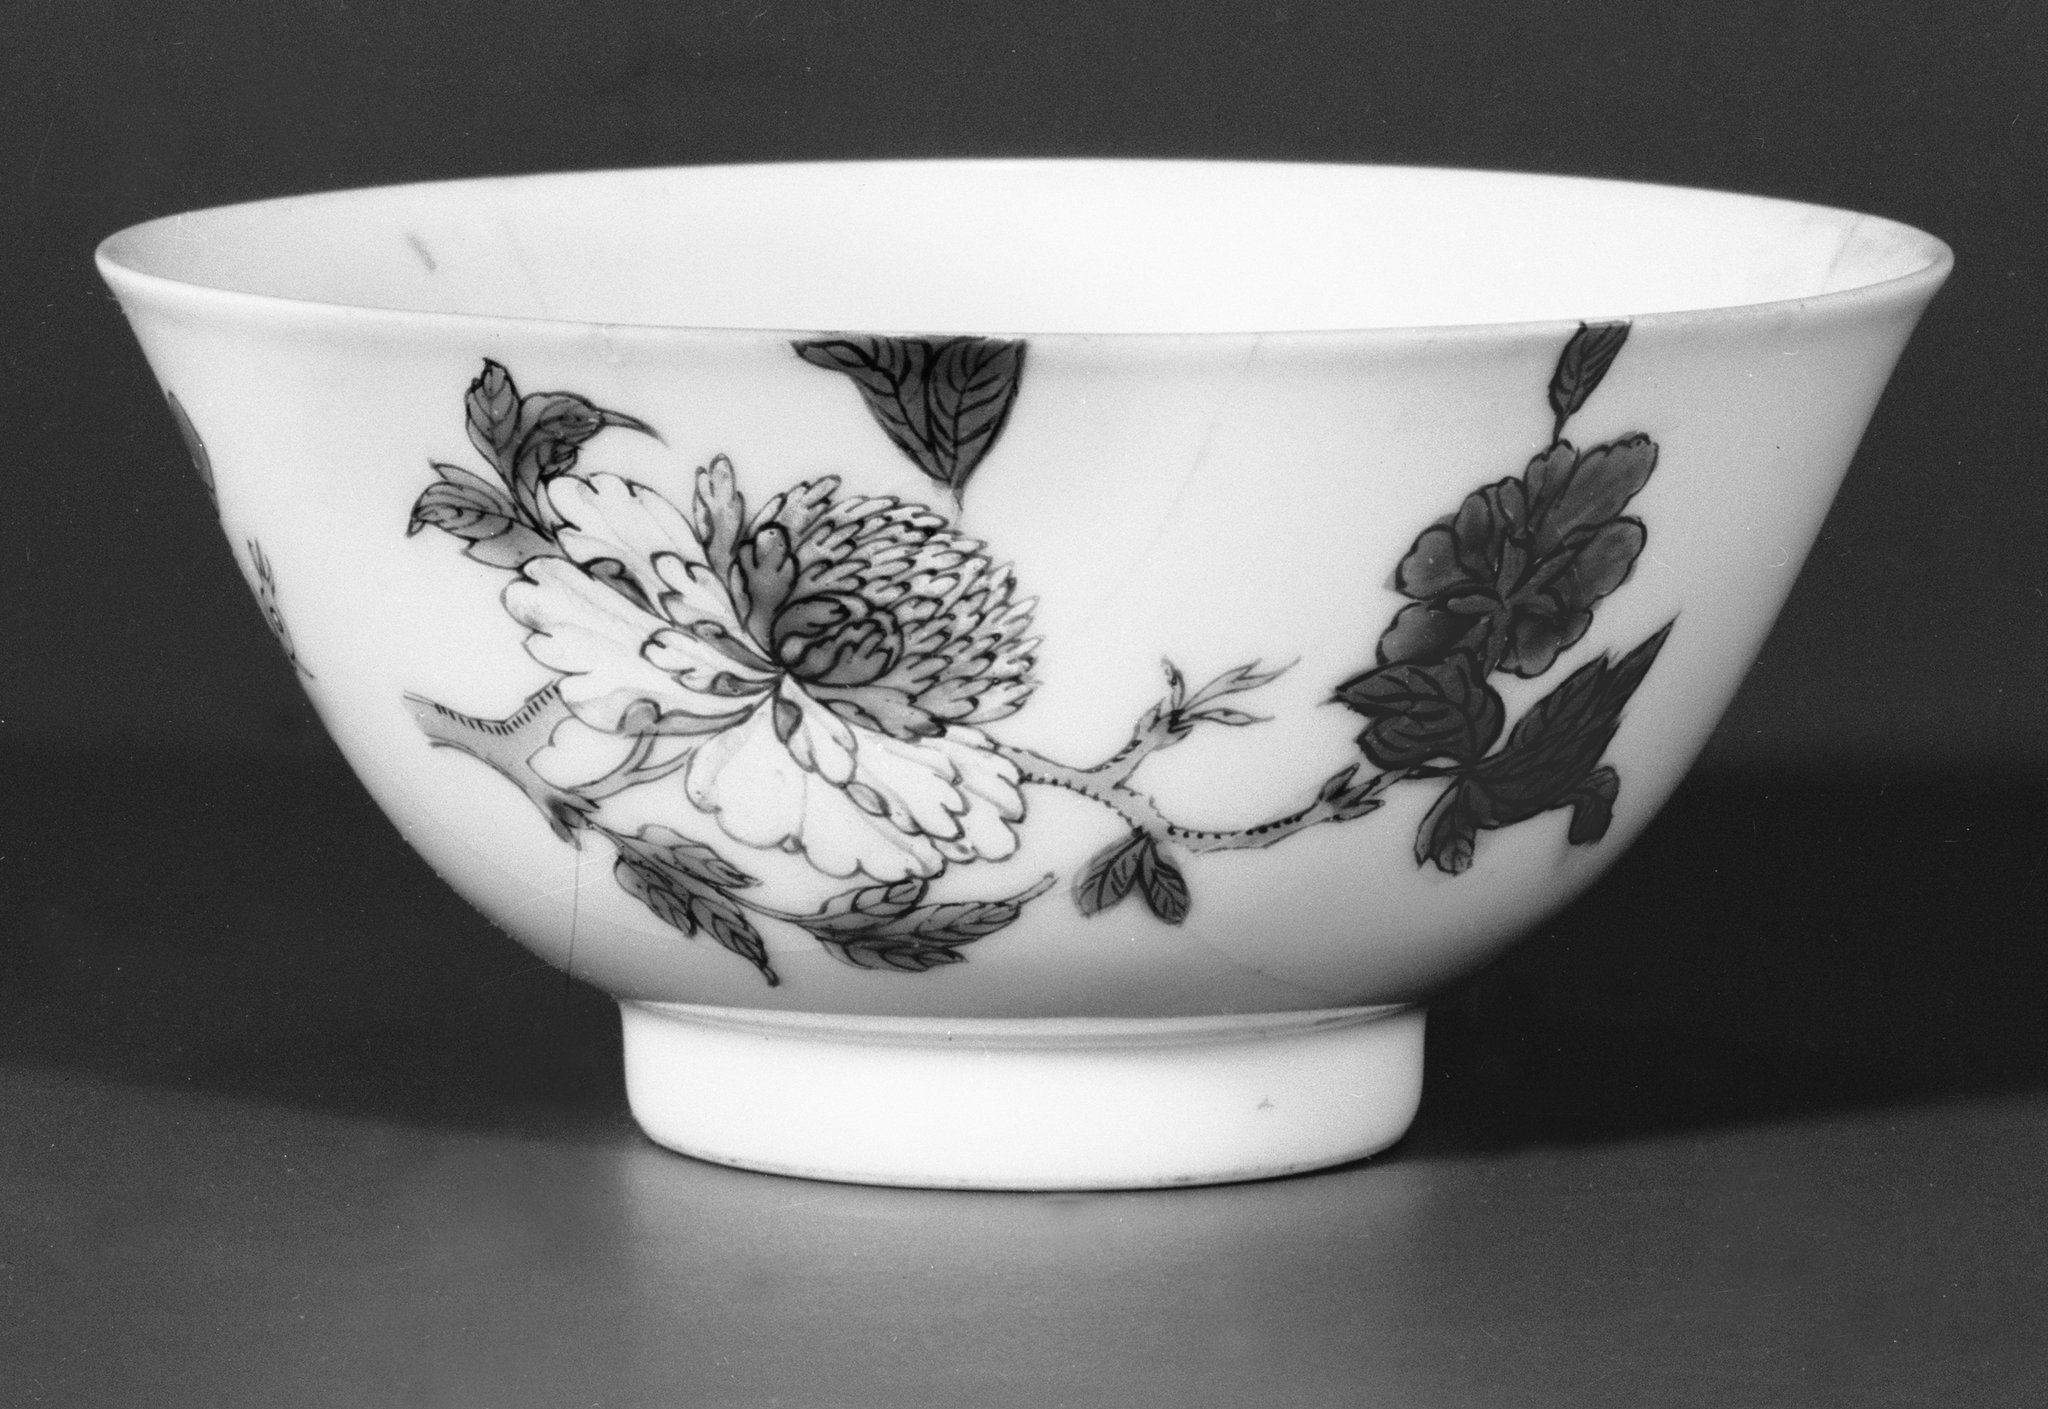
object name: bowl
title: Bowl with flowers (one of a pair)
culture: chinese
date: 1734-1766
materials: enamel, porcelain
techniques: overglaze, painting, polychrome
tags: flowers